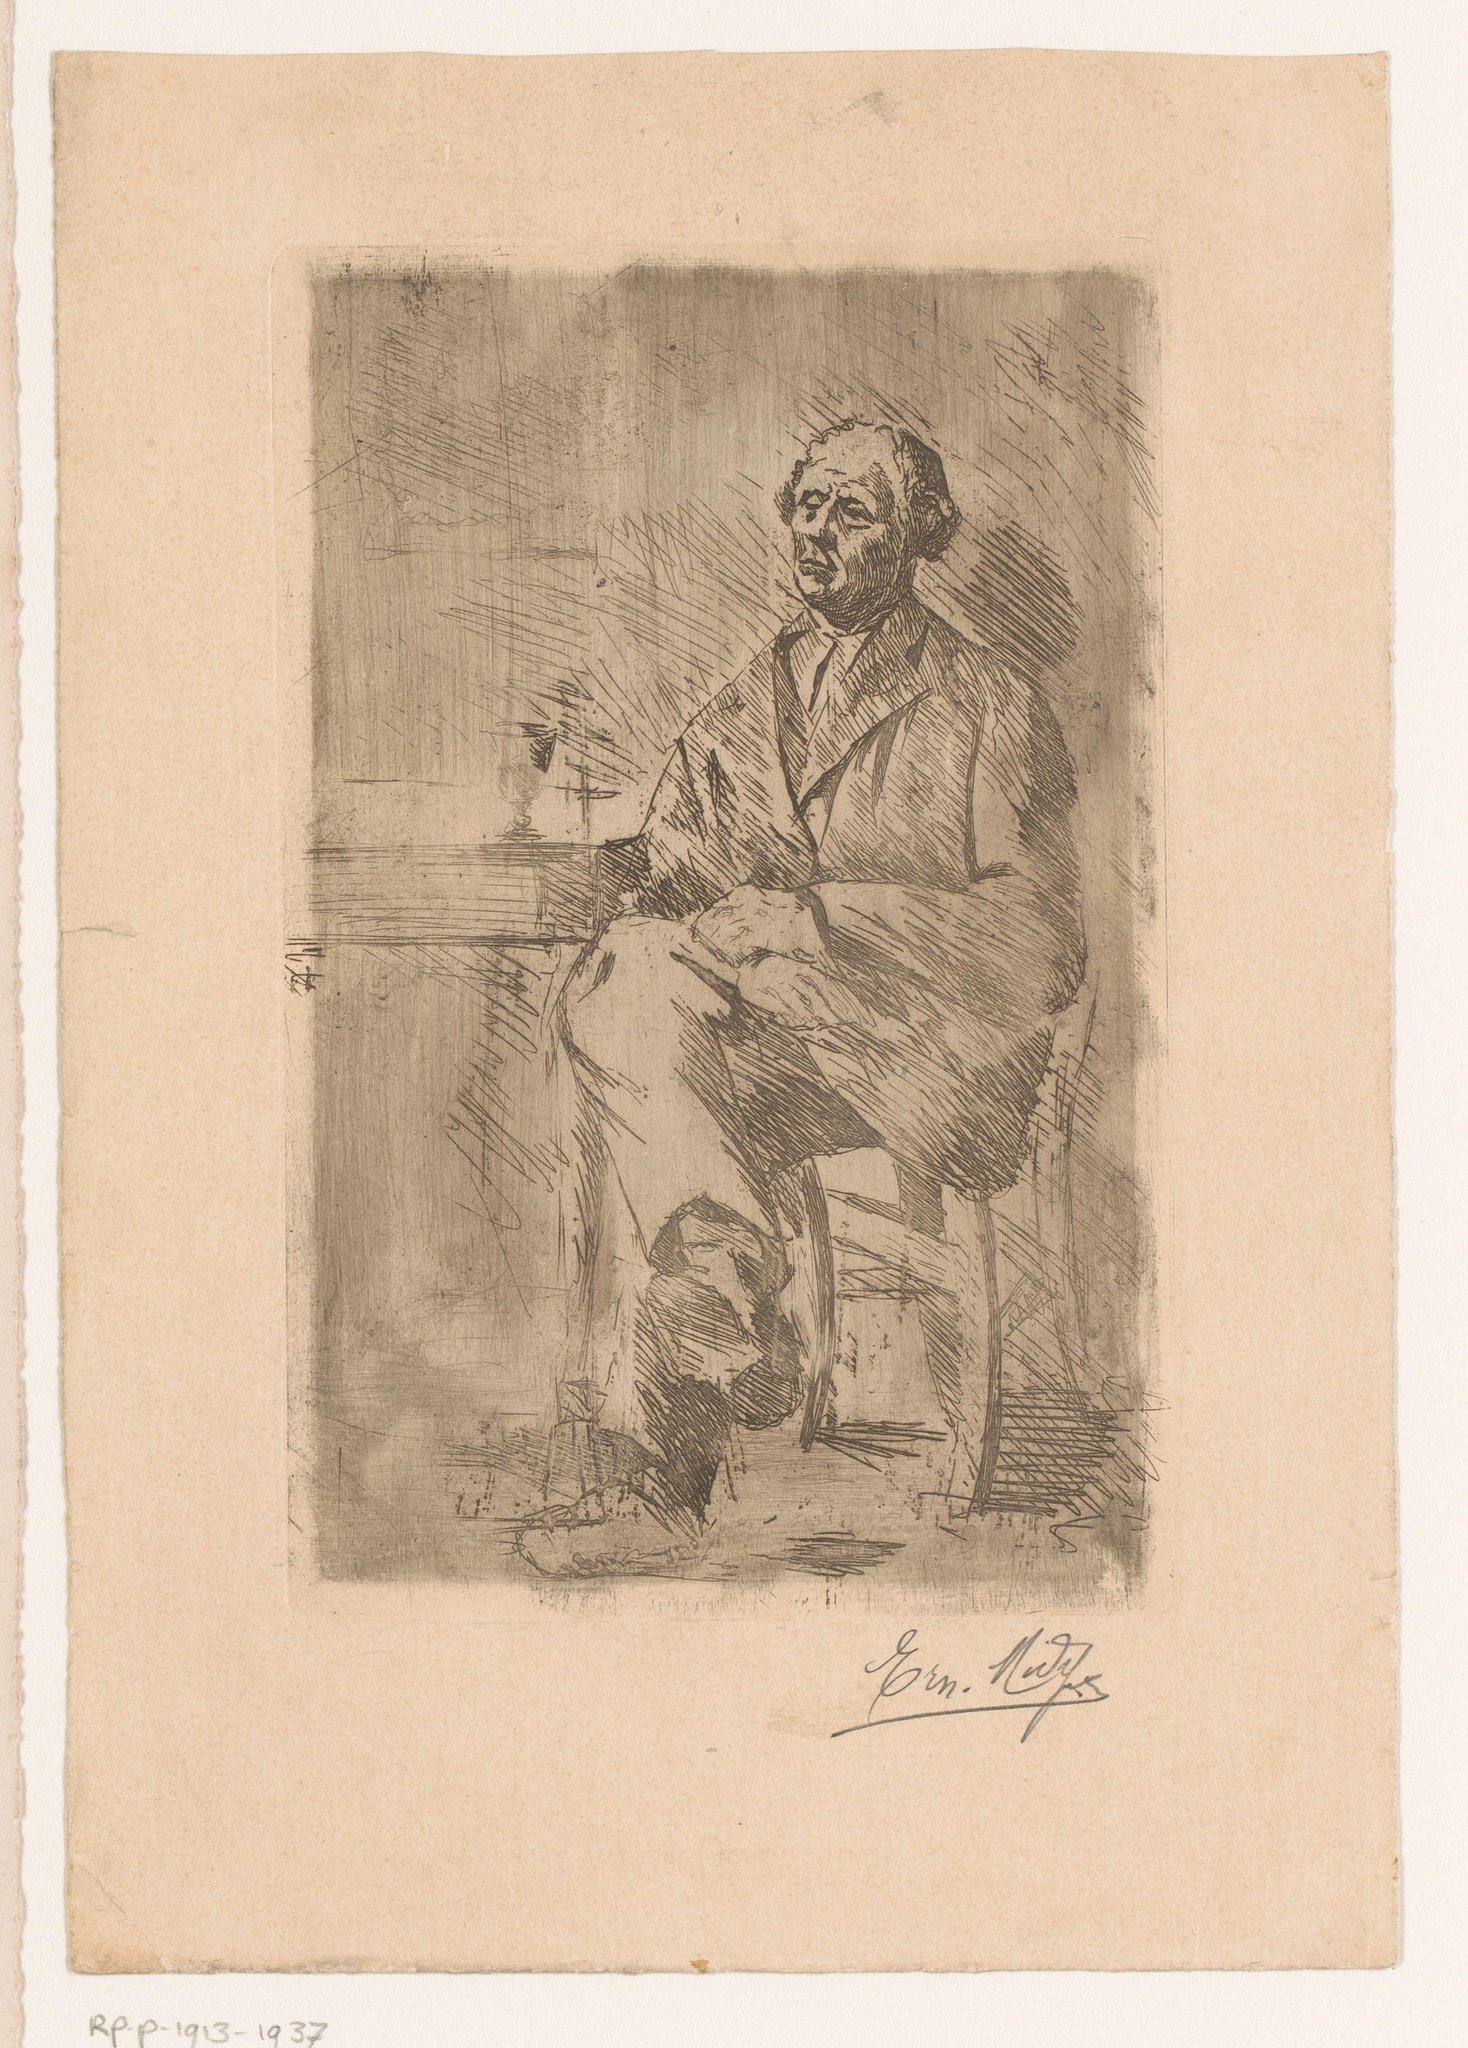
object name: print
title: Man gezeten aan een tafel met daarop een drinkglas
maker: ernest midy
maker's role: print maker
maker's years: 1878-1938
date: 1888-1913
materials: paper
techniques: etching, intaglio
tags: sitting figure, adult man, table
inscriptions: collector's mark: Lugt 2228